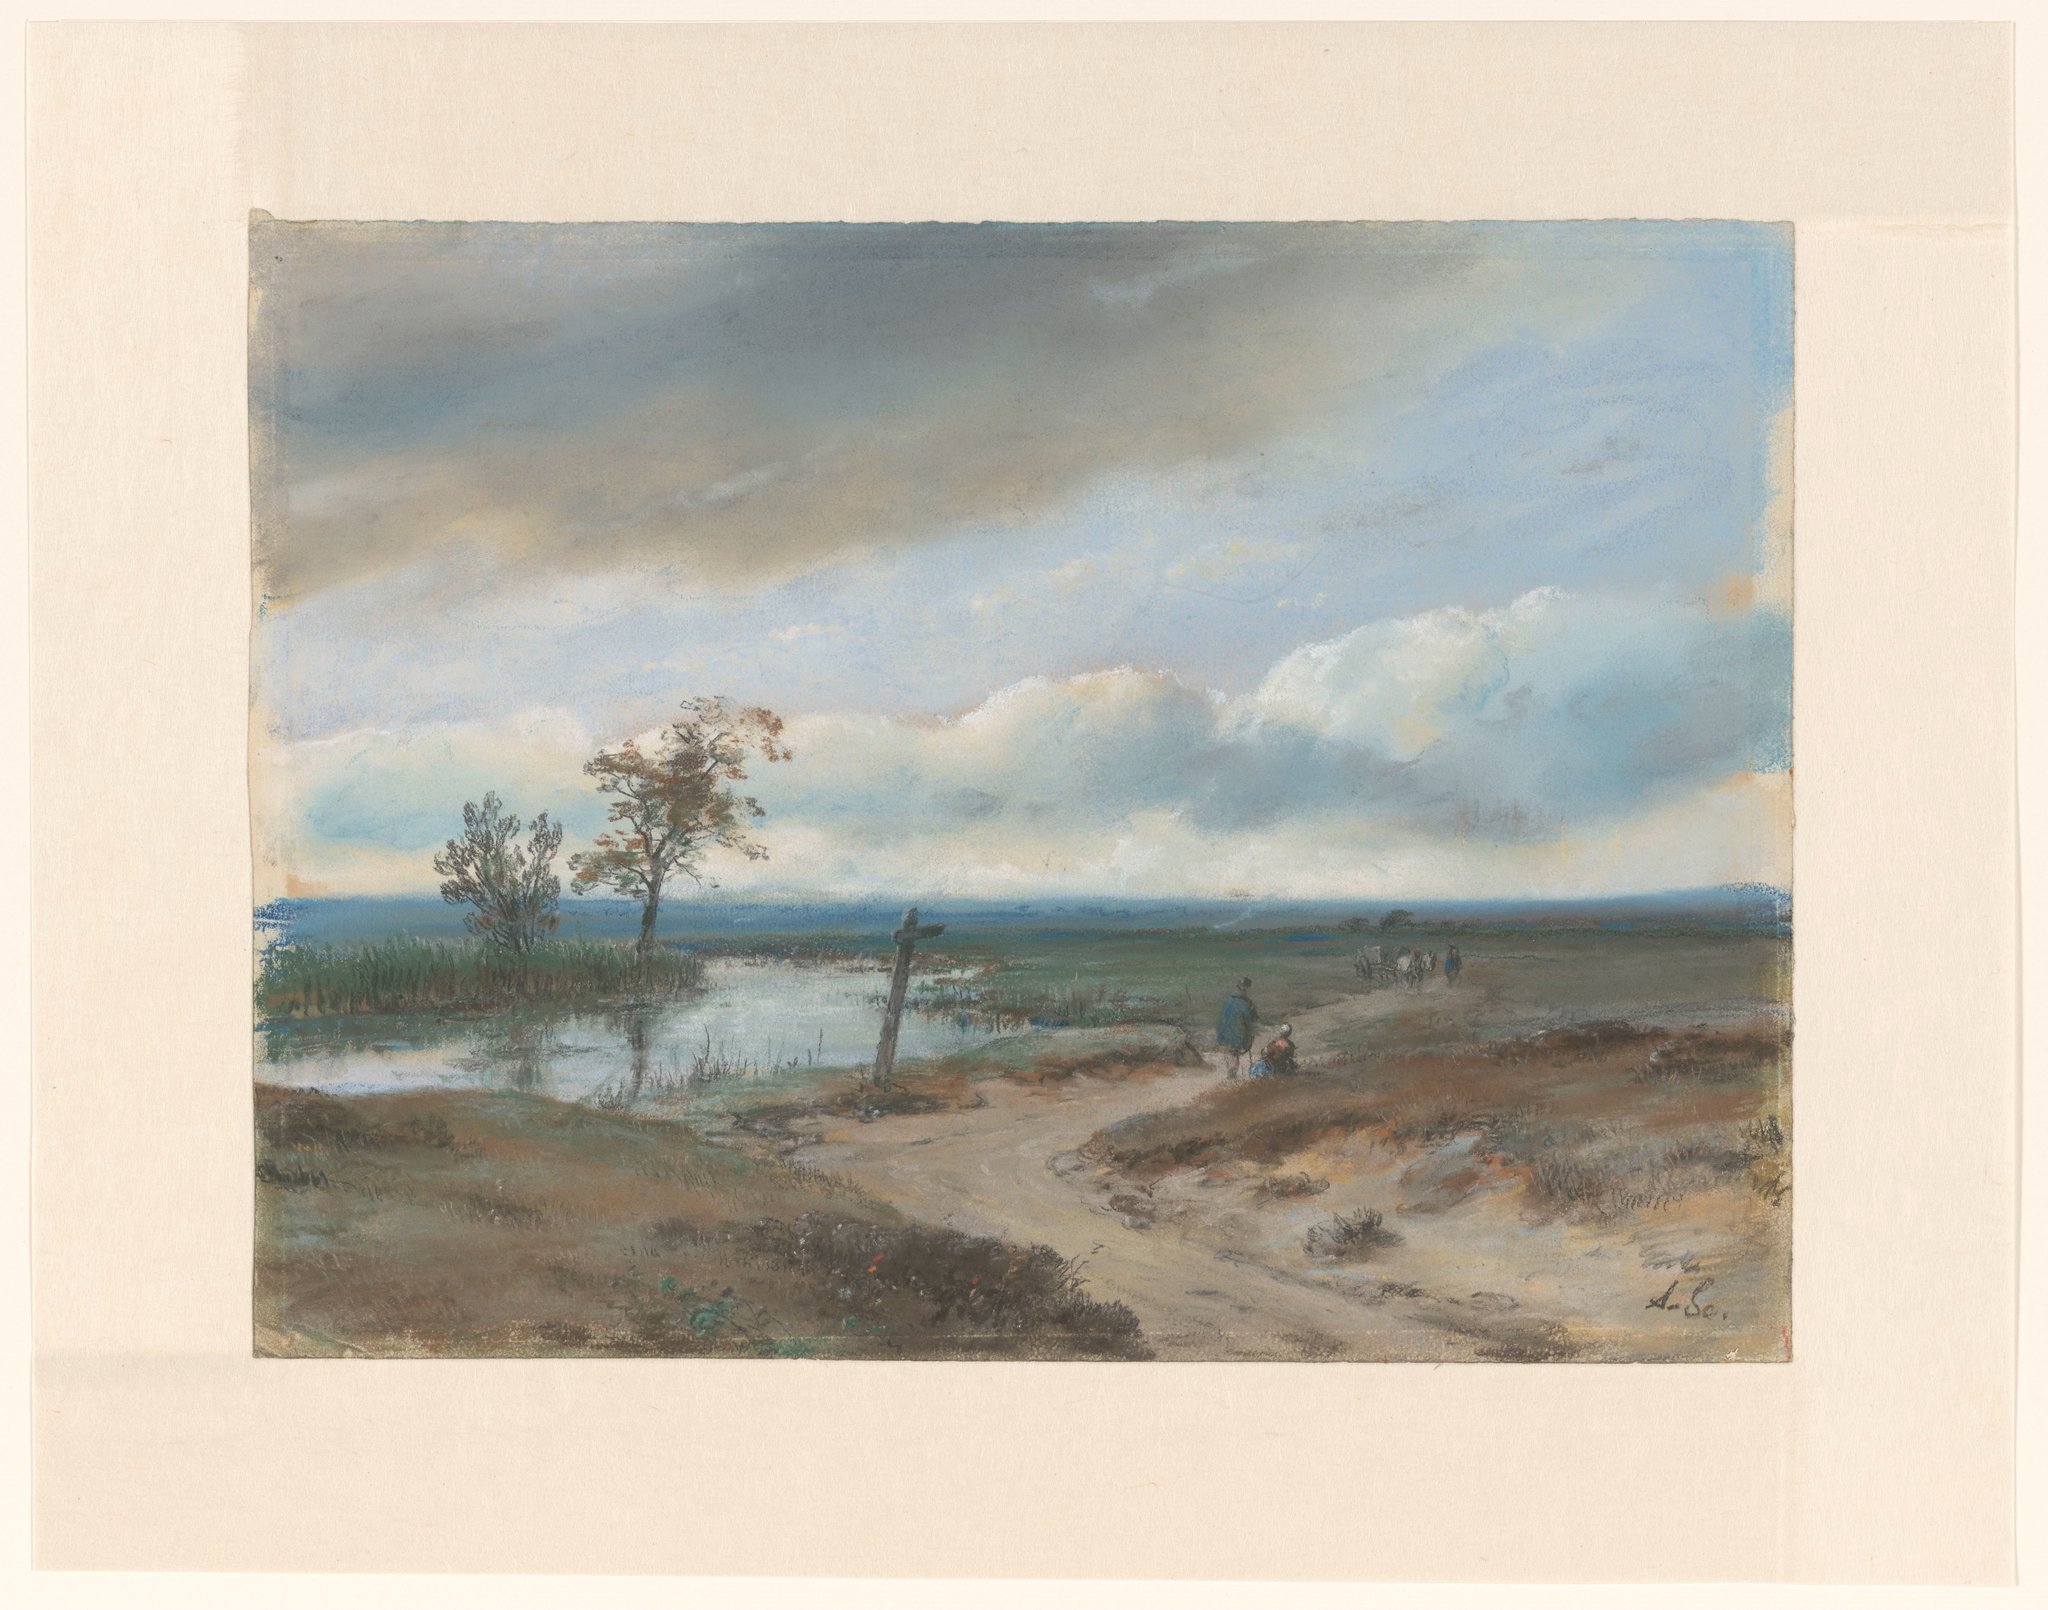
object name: drawing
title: Vennenlandschap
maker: andreas schelfhout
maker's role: draughtsman, painter, print maker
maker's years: 1787-1870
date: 1797-1870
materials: chalk, paper, pastel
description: Vlak, open landschap onder bewoklte lucht. Een zandweg waarlangs enige figuren lopen. Links een ven, en een wegwijzer.